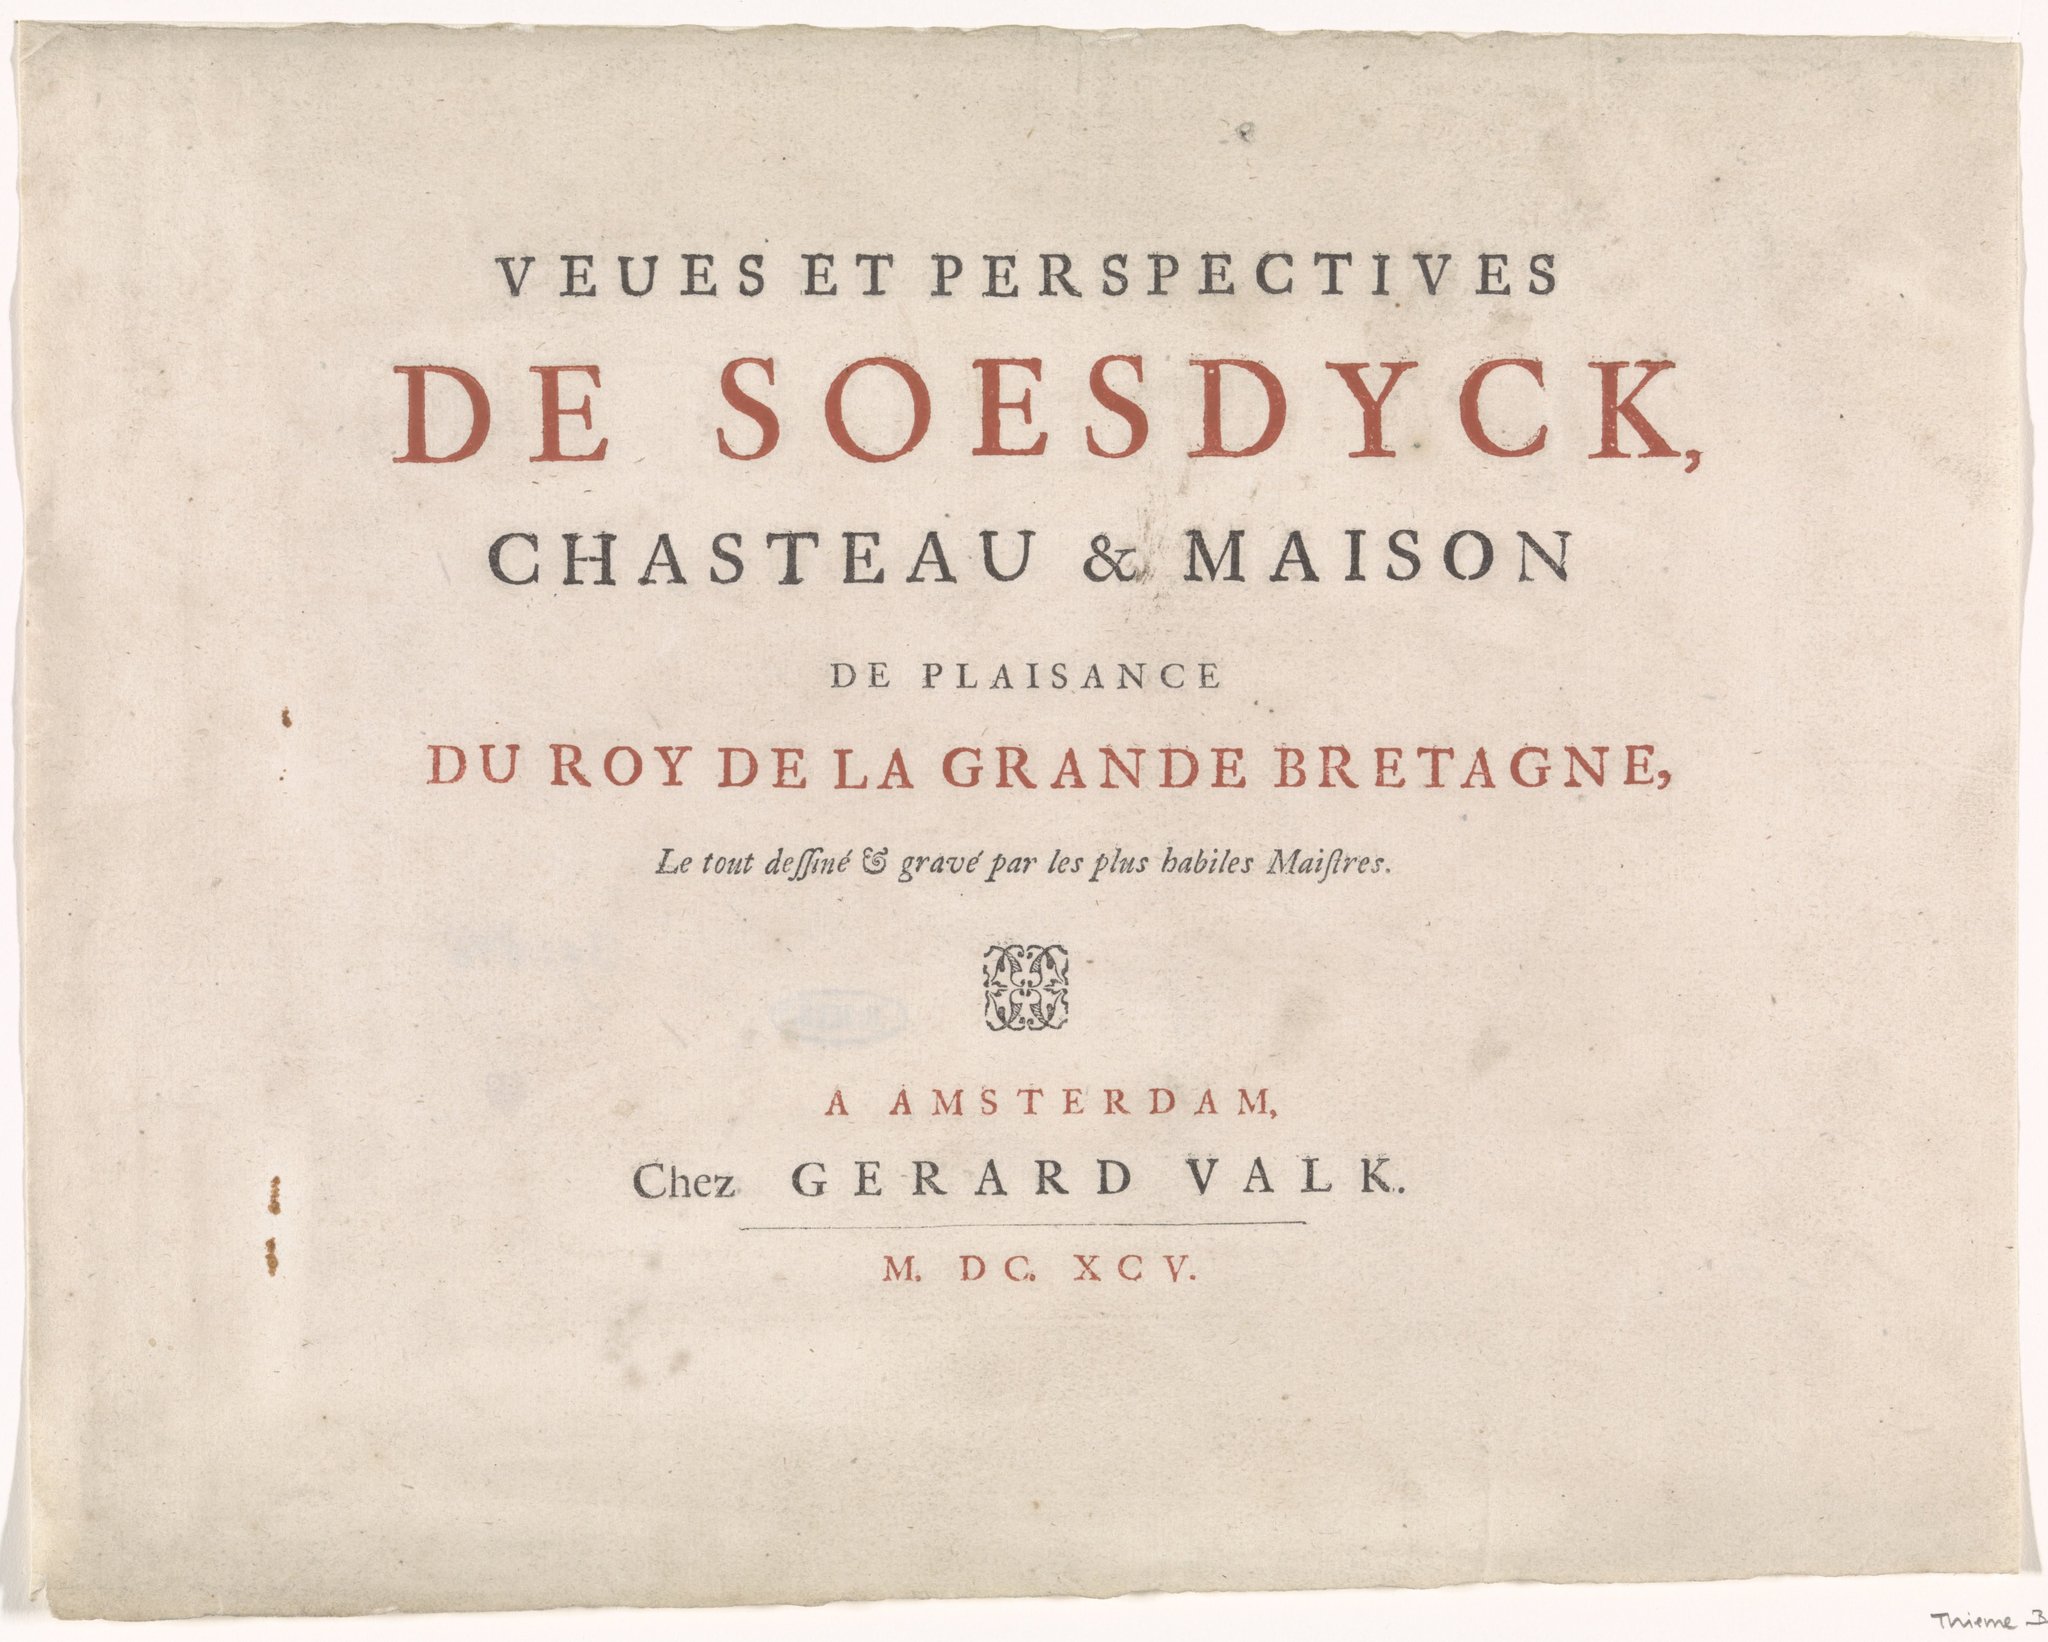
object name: titelblad, titelpagina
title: Titelpagina voor een serie gezichten op Soestdijk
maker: gerard valck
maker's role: print maker, publisher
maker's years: 1651-1726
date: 1695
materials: paper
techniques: letterpress printing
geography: amsterdam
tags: paleis soestdijk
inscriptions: collector's mark: Lugt 2228, collector's mark: Lugt 2760